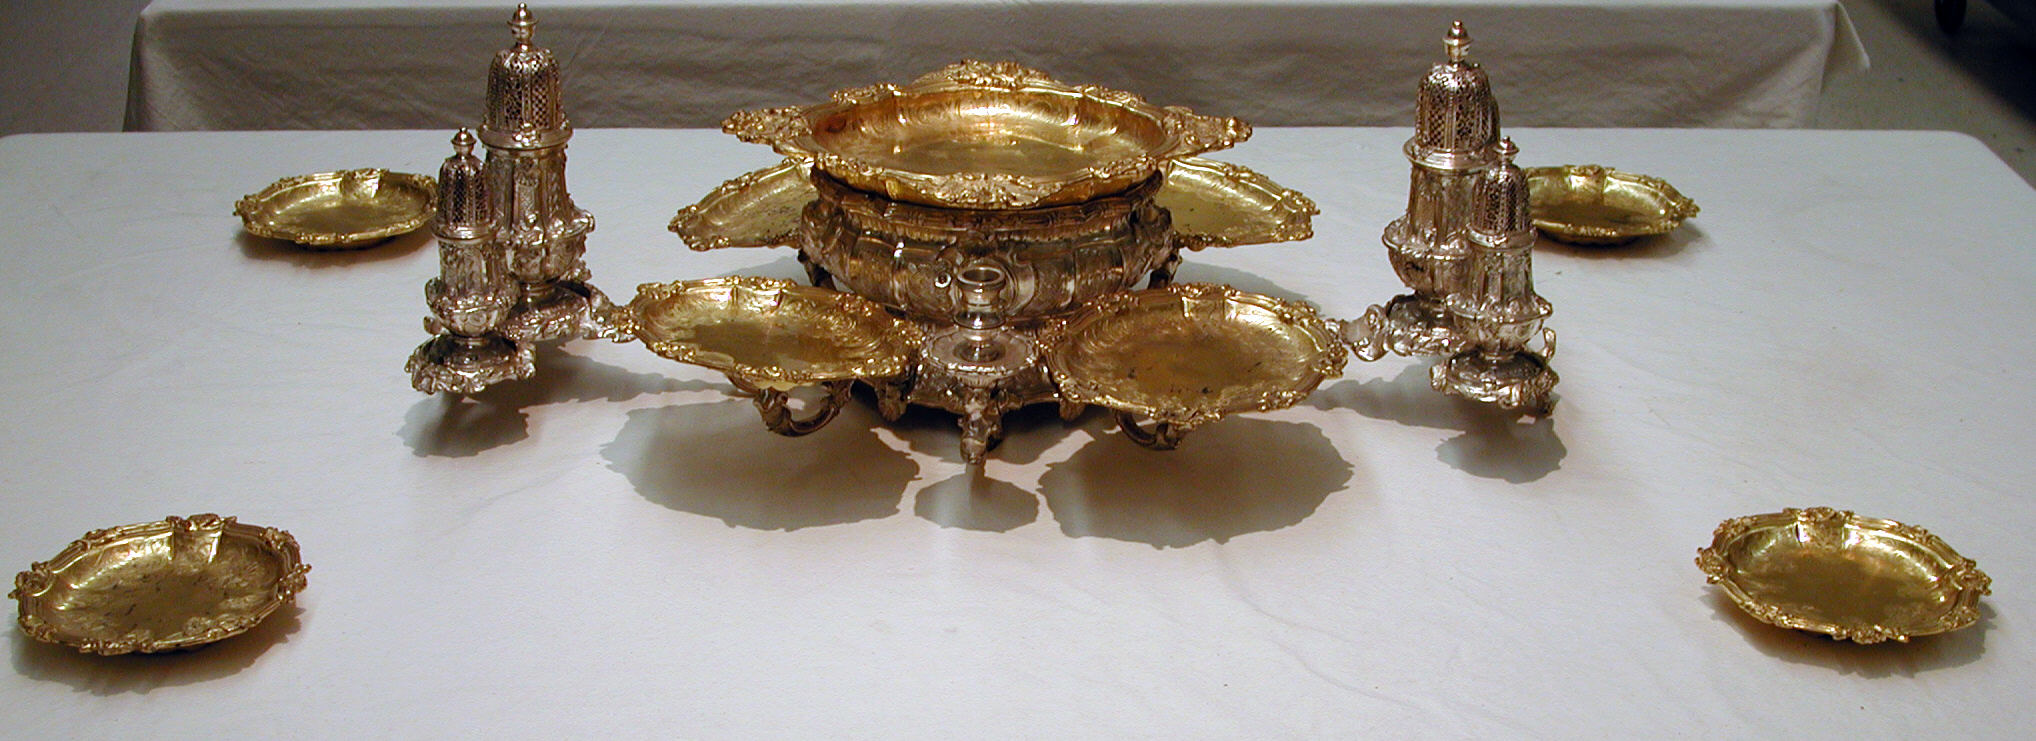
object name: centerpiece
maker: paul de lamerie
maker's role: maker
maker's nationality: british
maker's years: 1688-1751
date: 1801-1900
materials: metal, silver